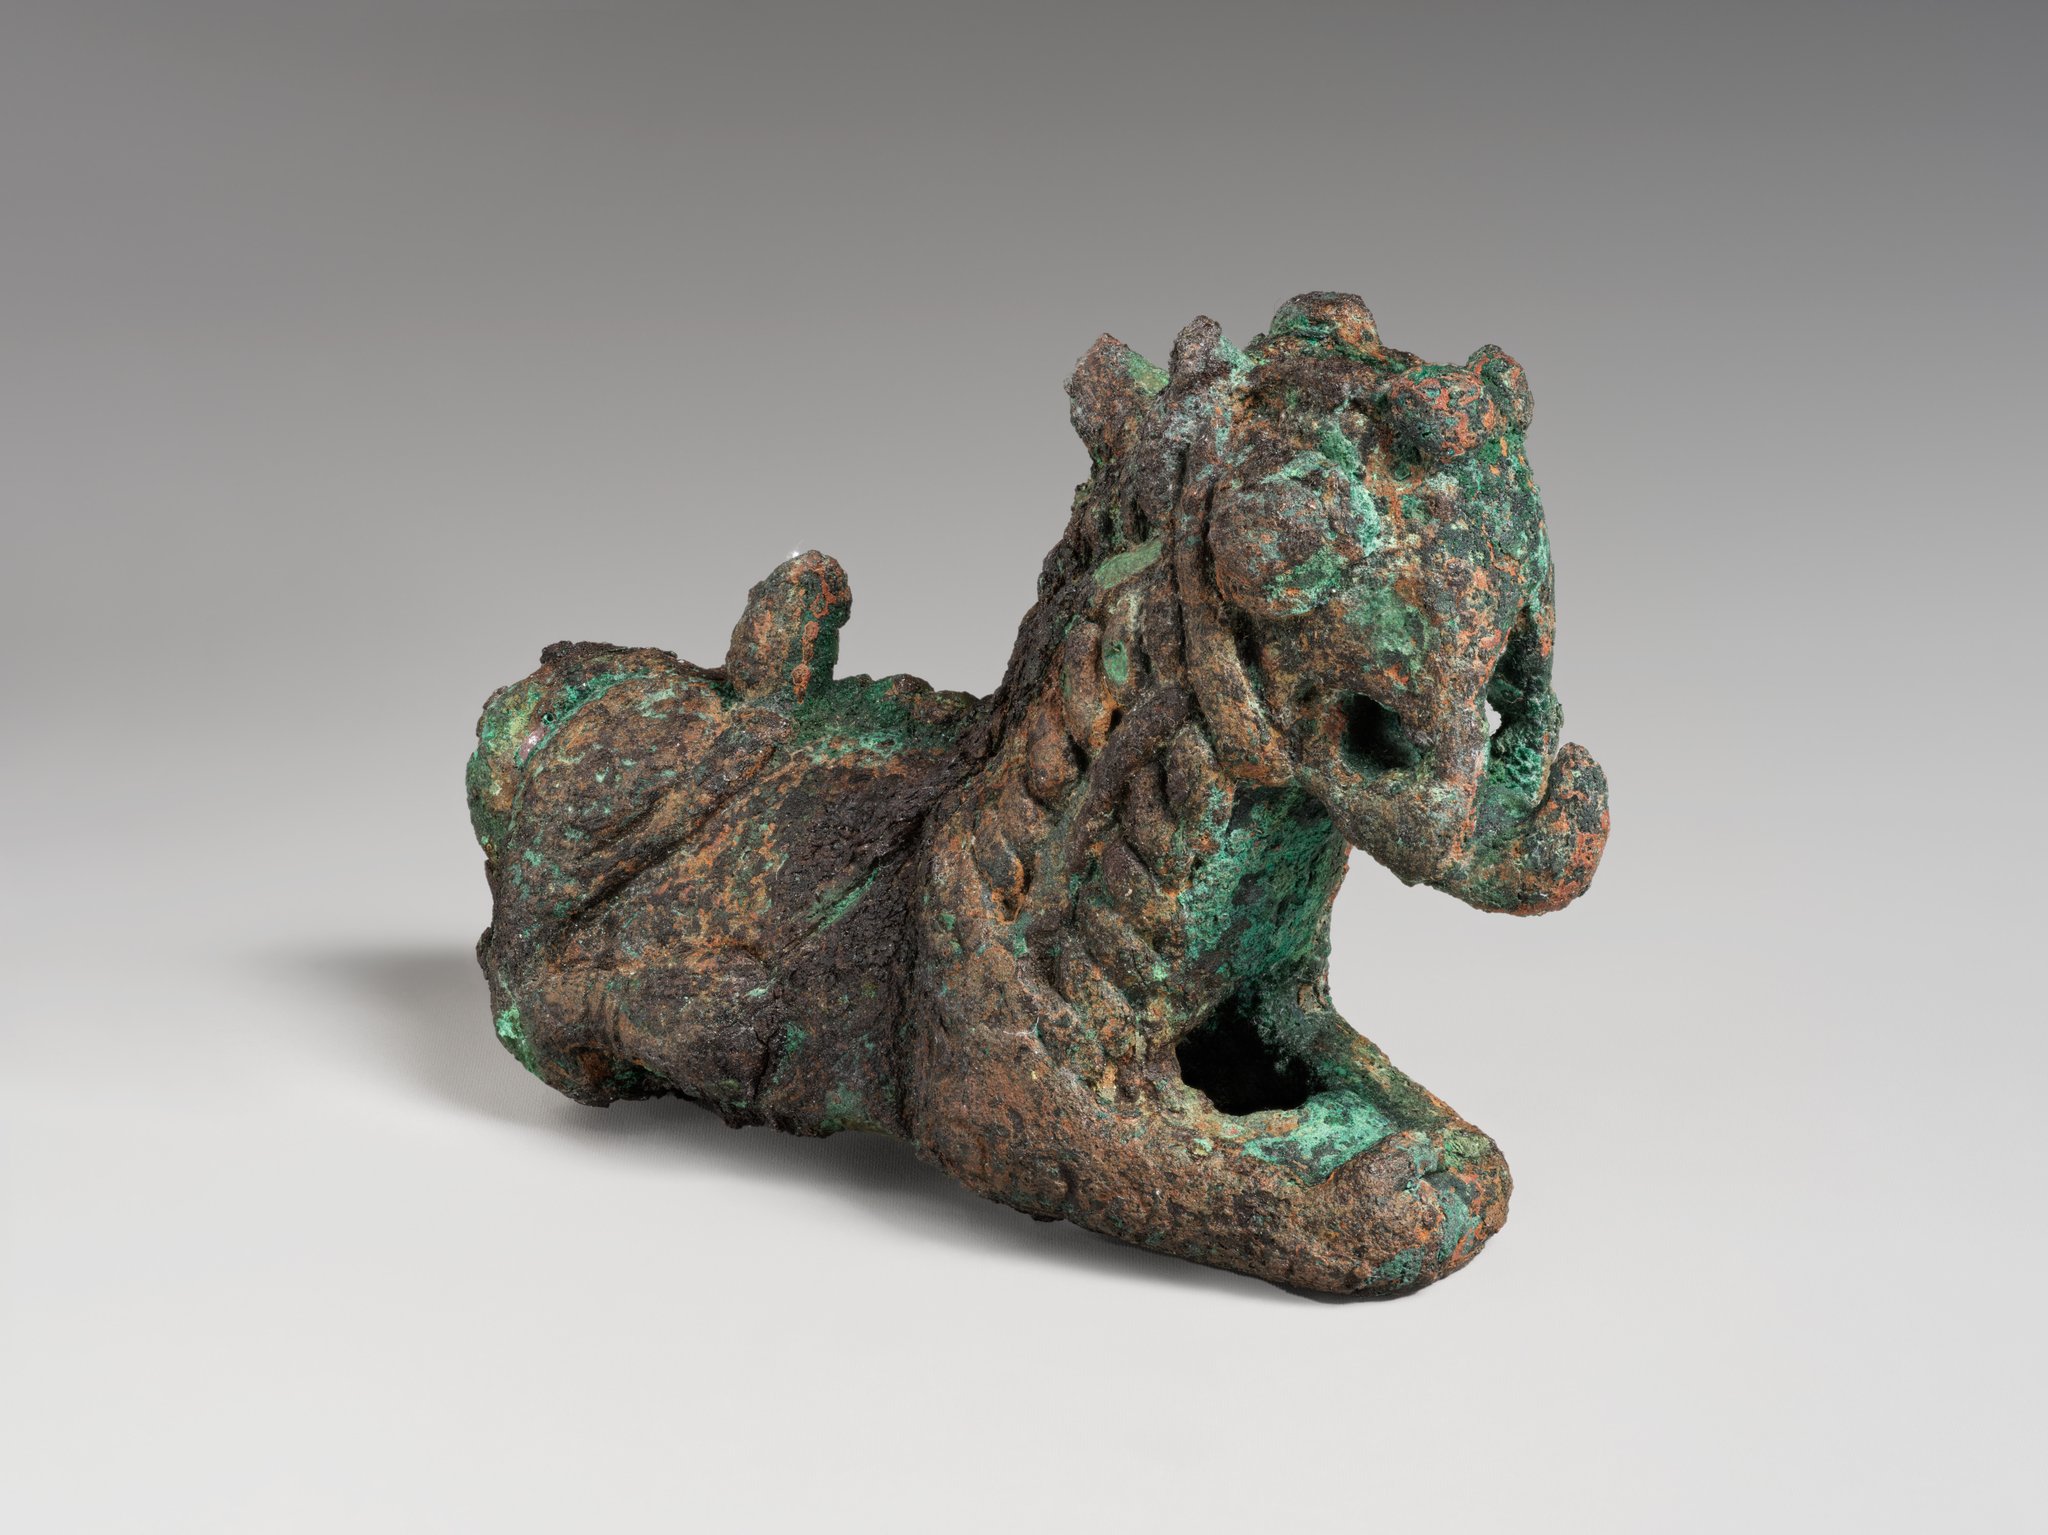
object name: pin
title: Lion pin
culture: iranian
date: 900-801 BCE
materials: bronze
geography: iran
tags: lions